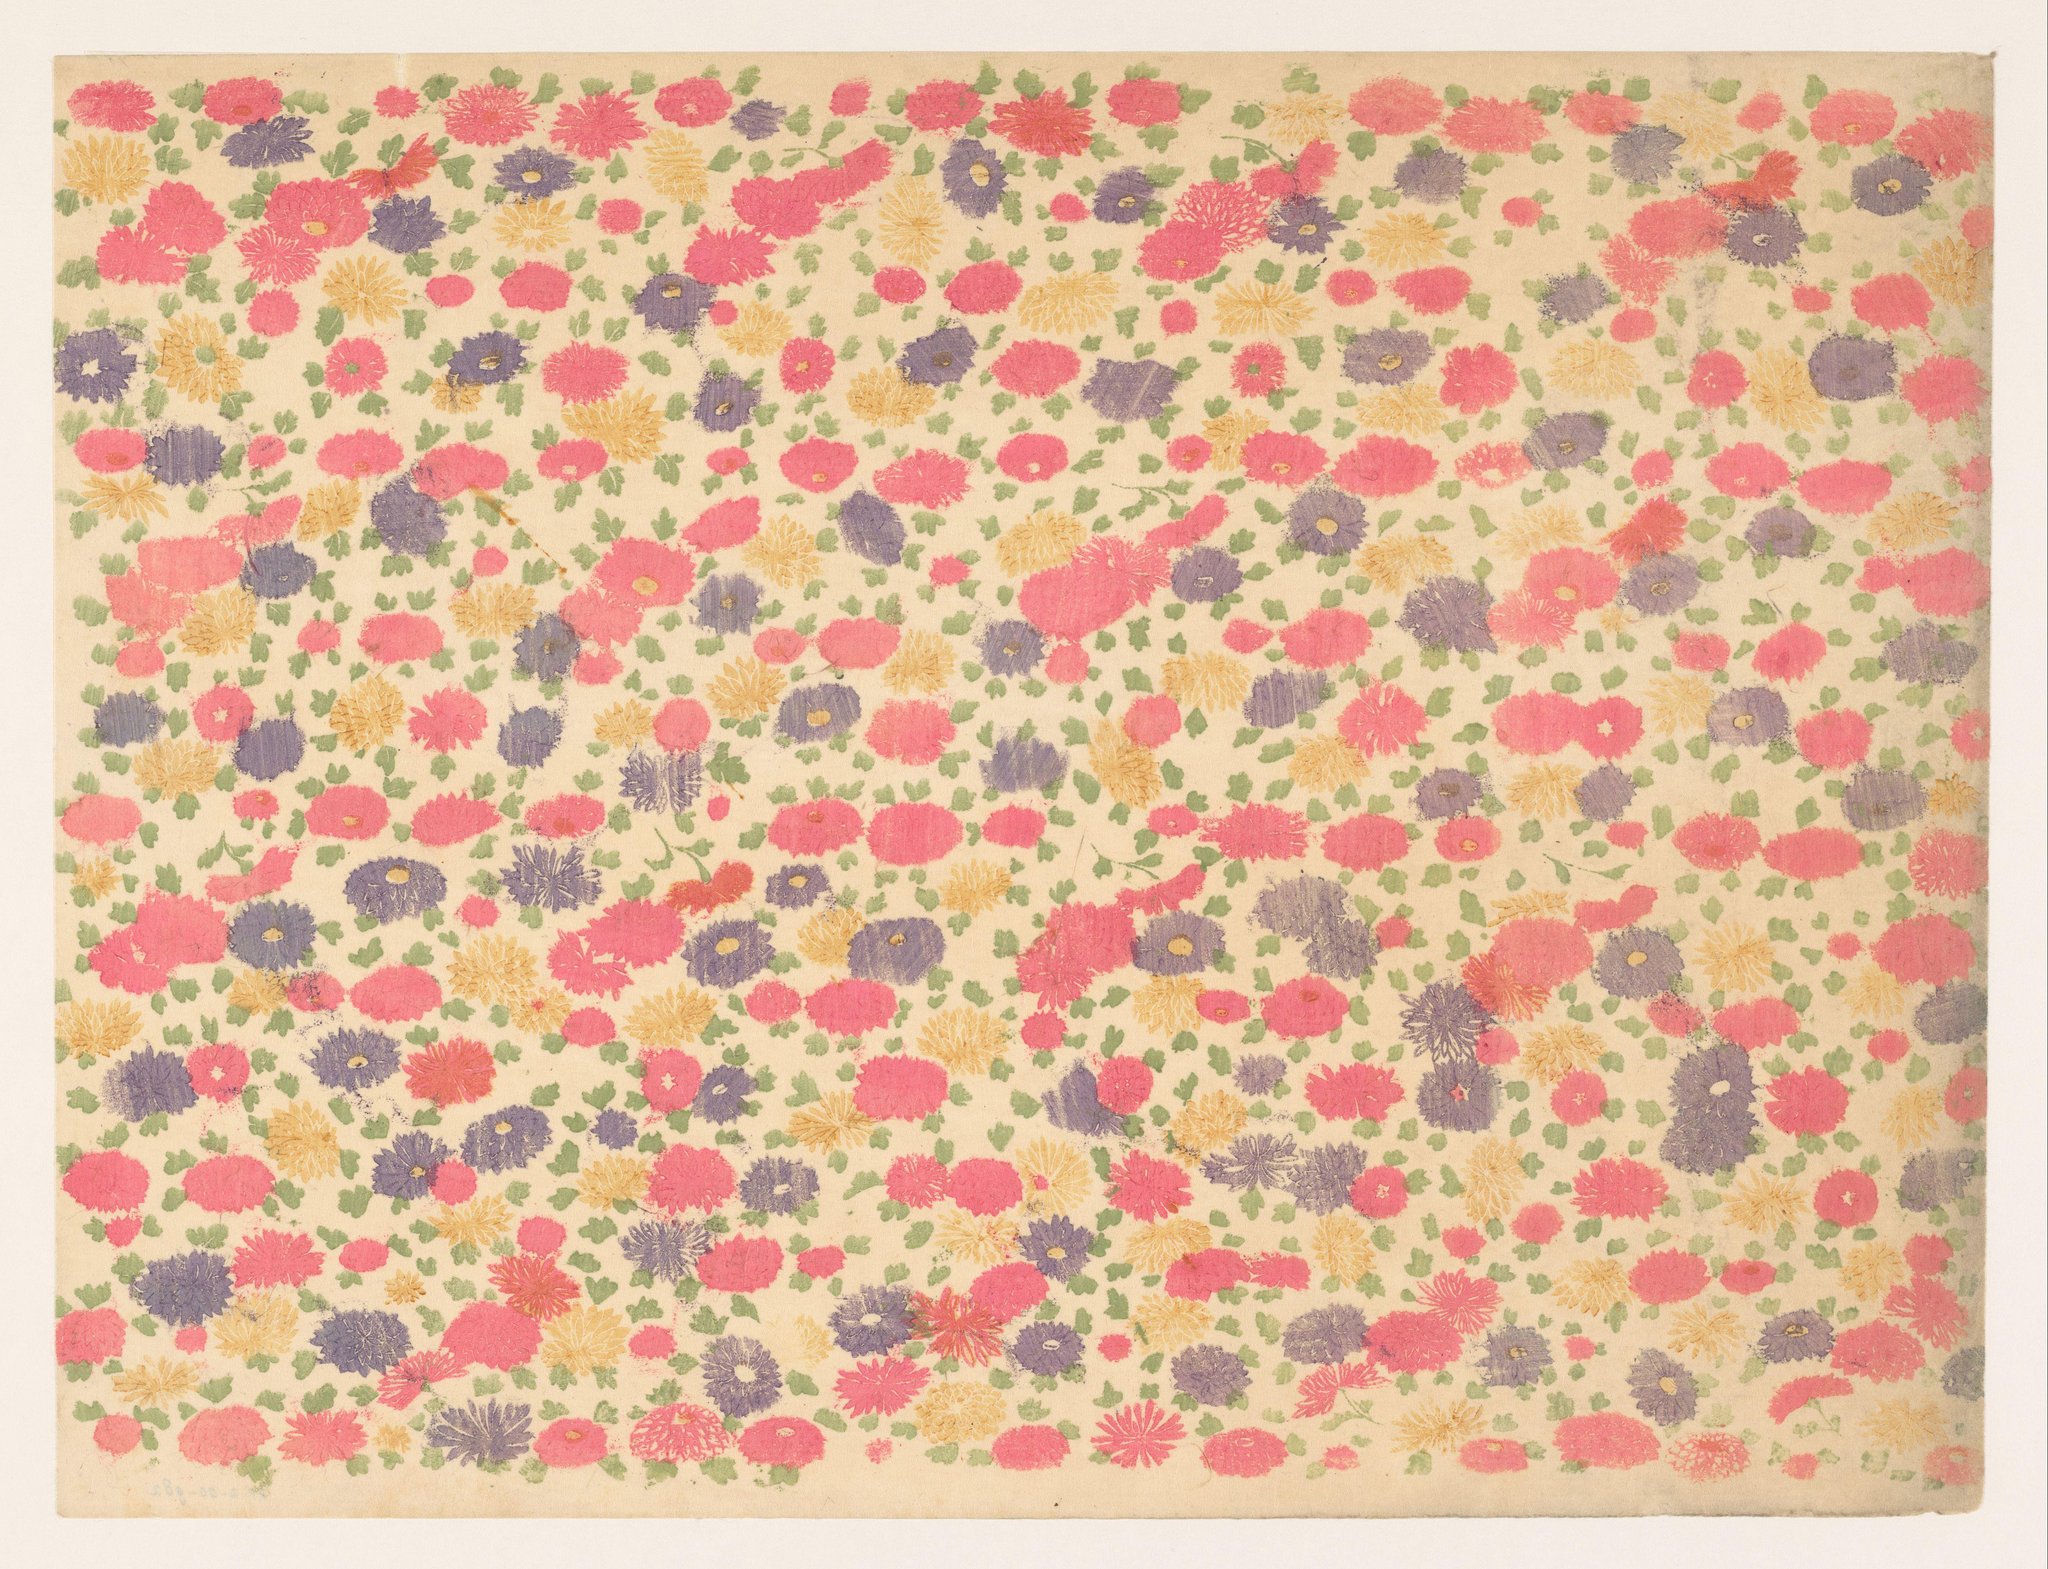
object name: decorated paper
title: Strooipatroon van bloemen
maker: Anonymous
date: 1860-1930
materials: paper, paint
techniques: printing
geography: japan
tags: ornament derived from plant forms